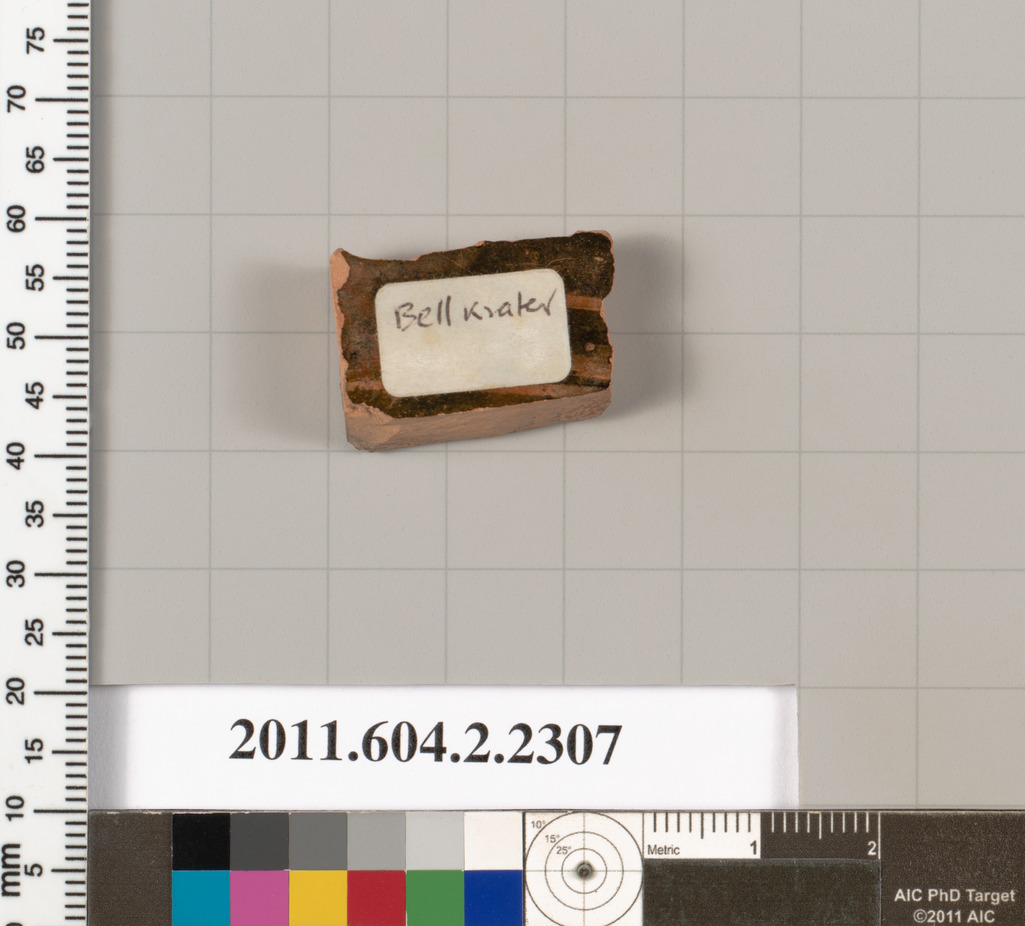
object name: bell krater fragment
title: Terracotta fragment of a bell-krater (bowl for mixing wine and water)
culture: greek, attic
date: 475-451 BCE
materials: terracotta